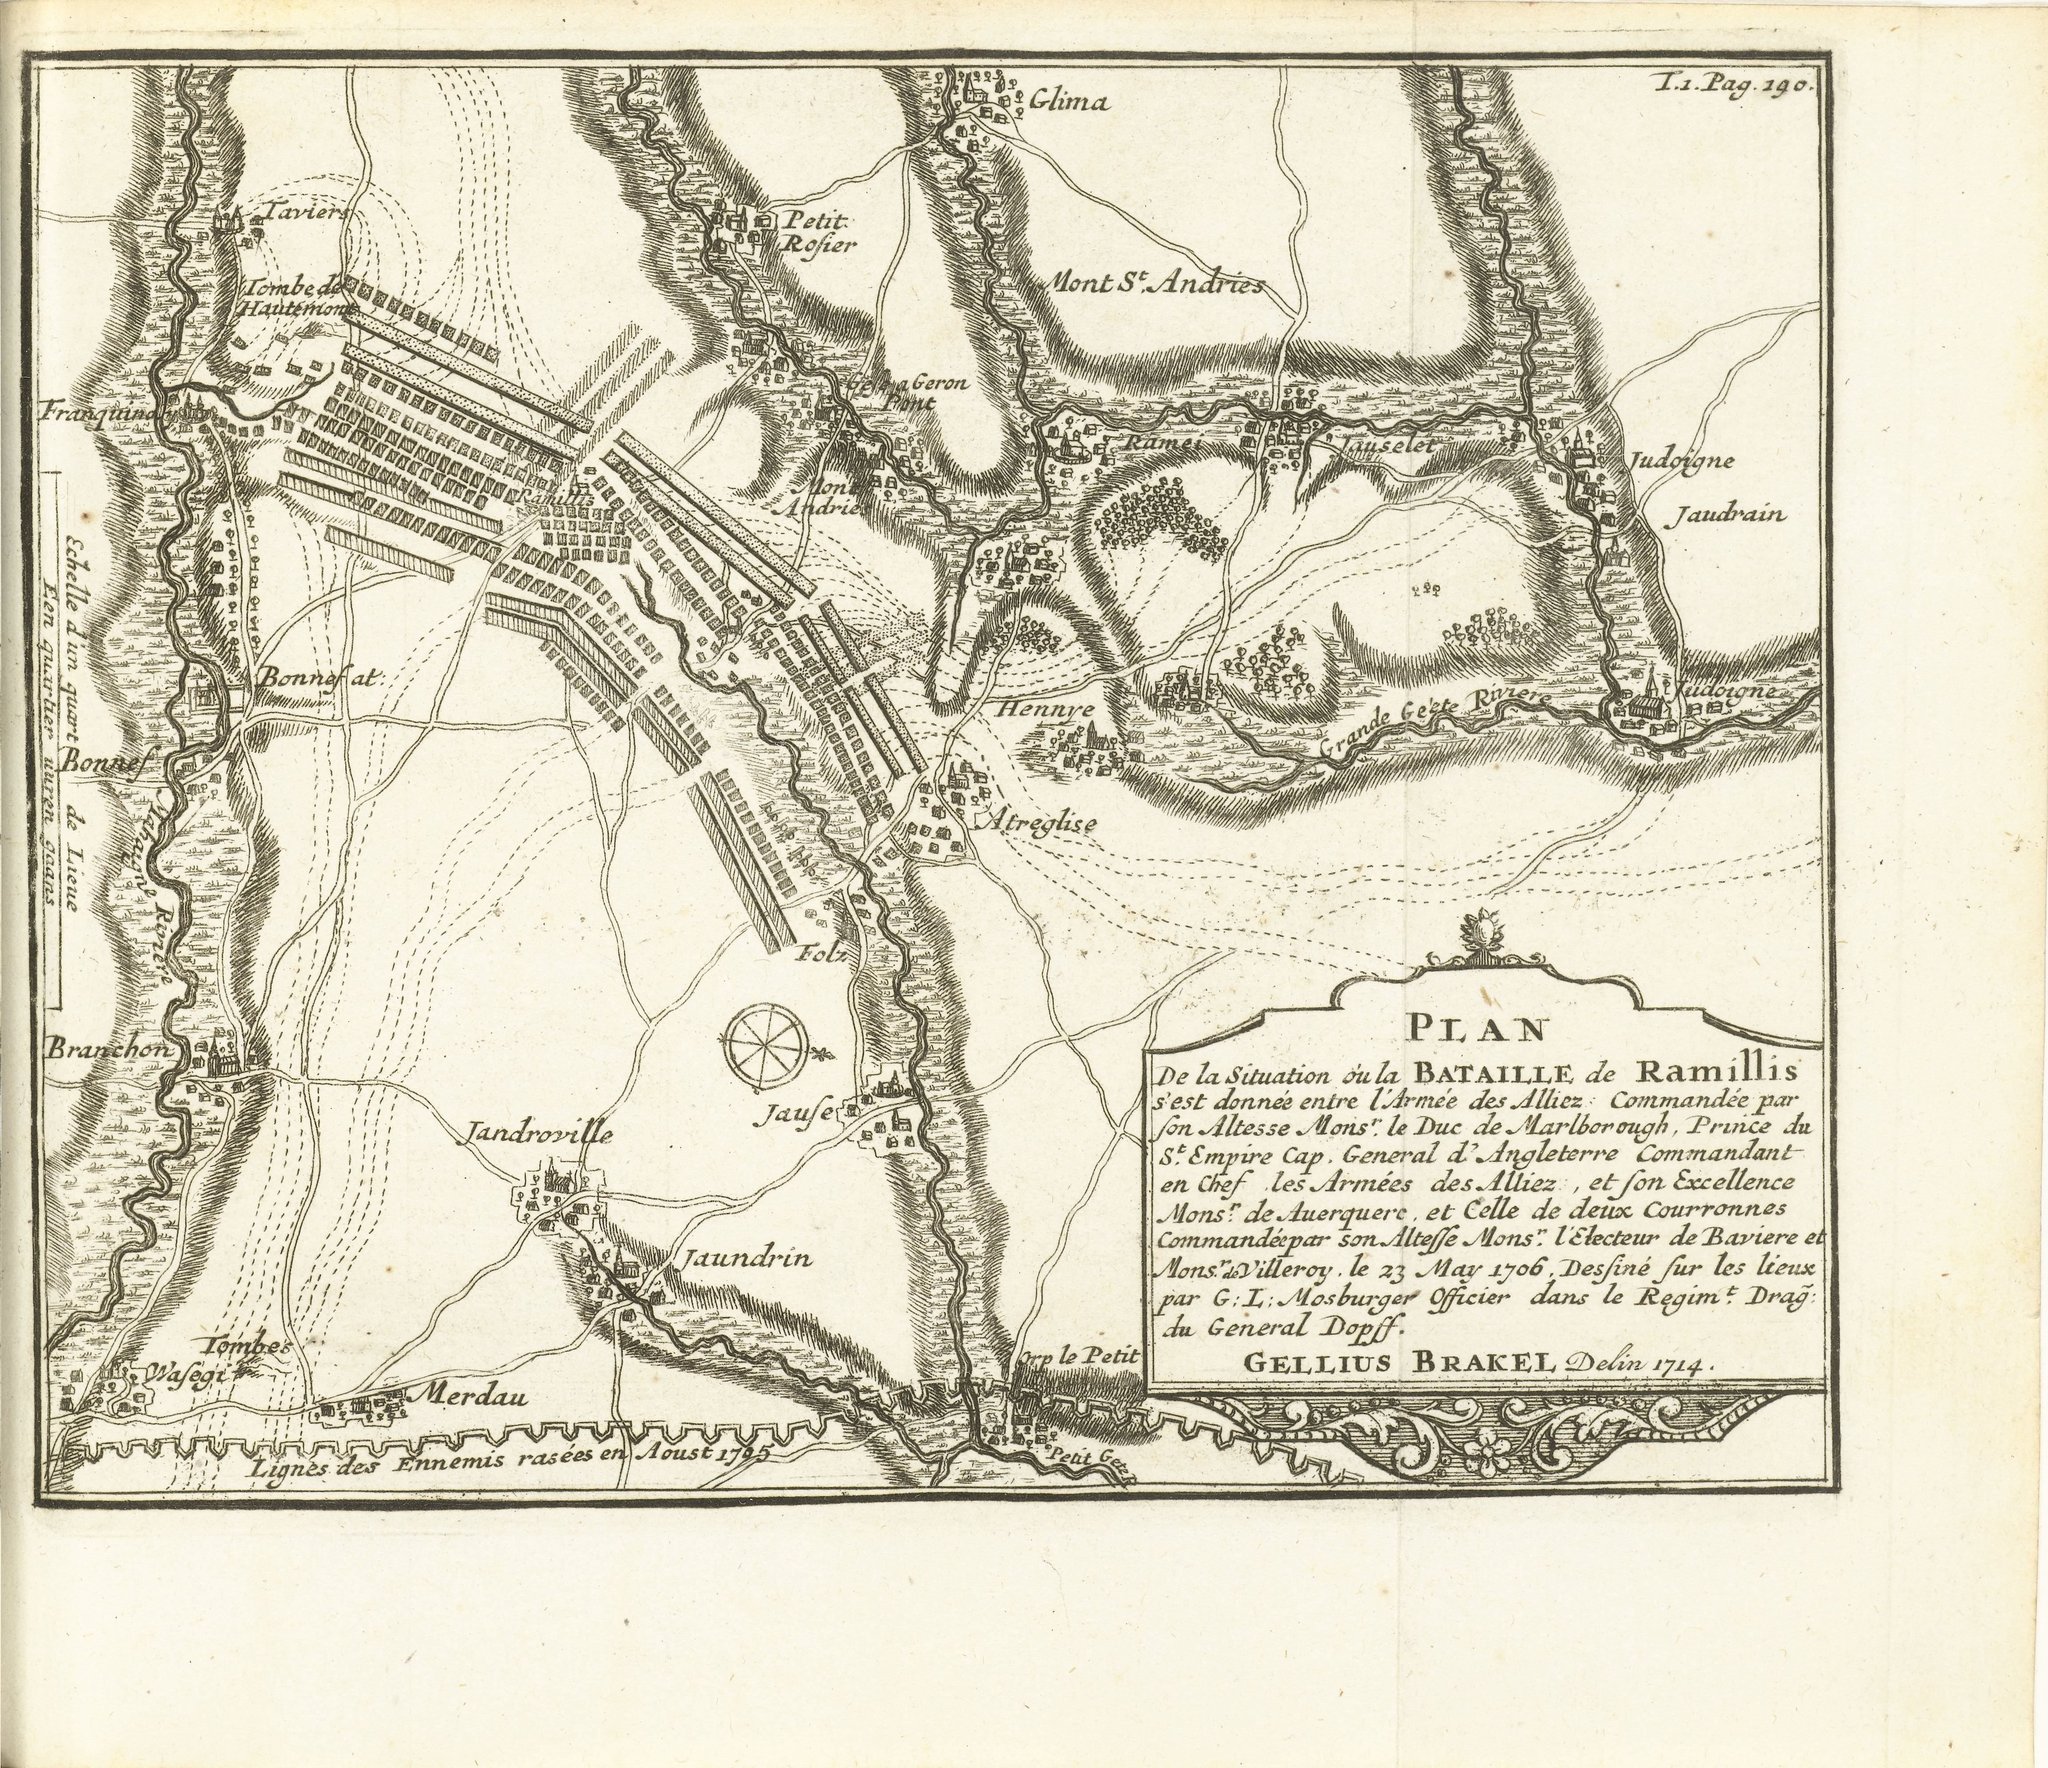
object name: map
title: Plan de la Ville Chateau et Fort de Huy assiegez par les Armees de S.A.E. de Baviere & du Marechal de Villeroy le 26 May 1705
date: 1714-1716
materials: paper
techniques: etching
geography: northern netherlands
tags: johan willem friso (prins van oranje-nassau), maps of separate countries or regions, battle (+ land forces)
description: Kaart met de slag bij Ramillies, veldslag tussen de Fransen en de Geallieerden, 23 mei 1706. Illustratie in de Nederlandse vertaling uit 1716 van J. Lamigue, Het leven van Zyne Hoogheit Johan Willem Friso, dl. I, p. 190/191.